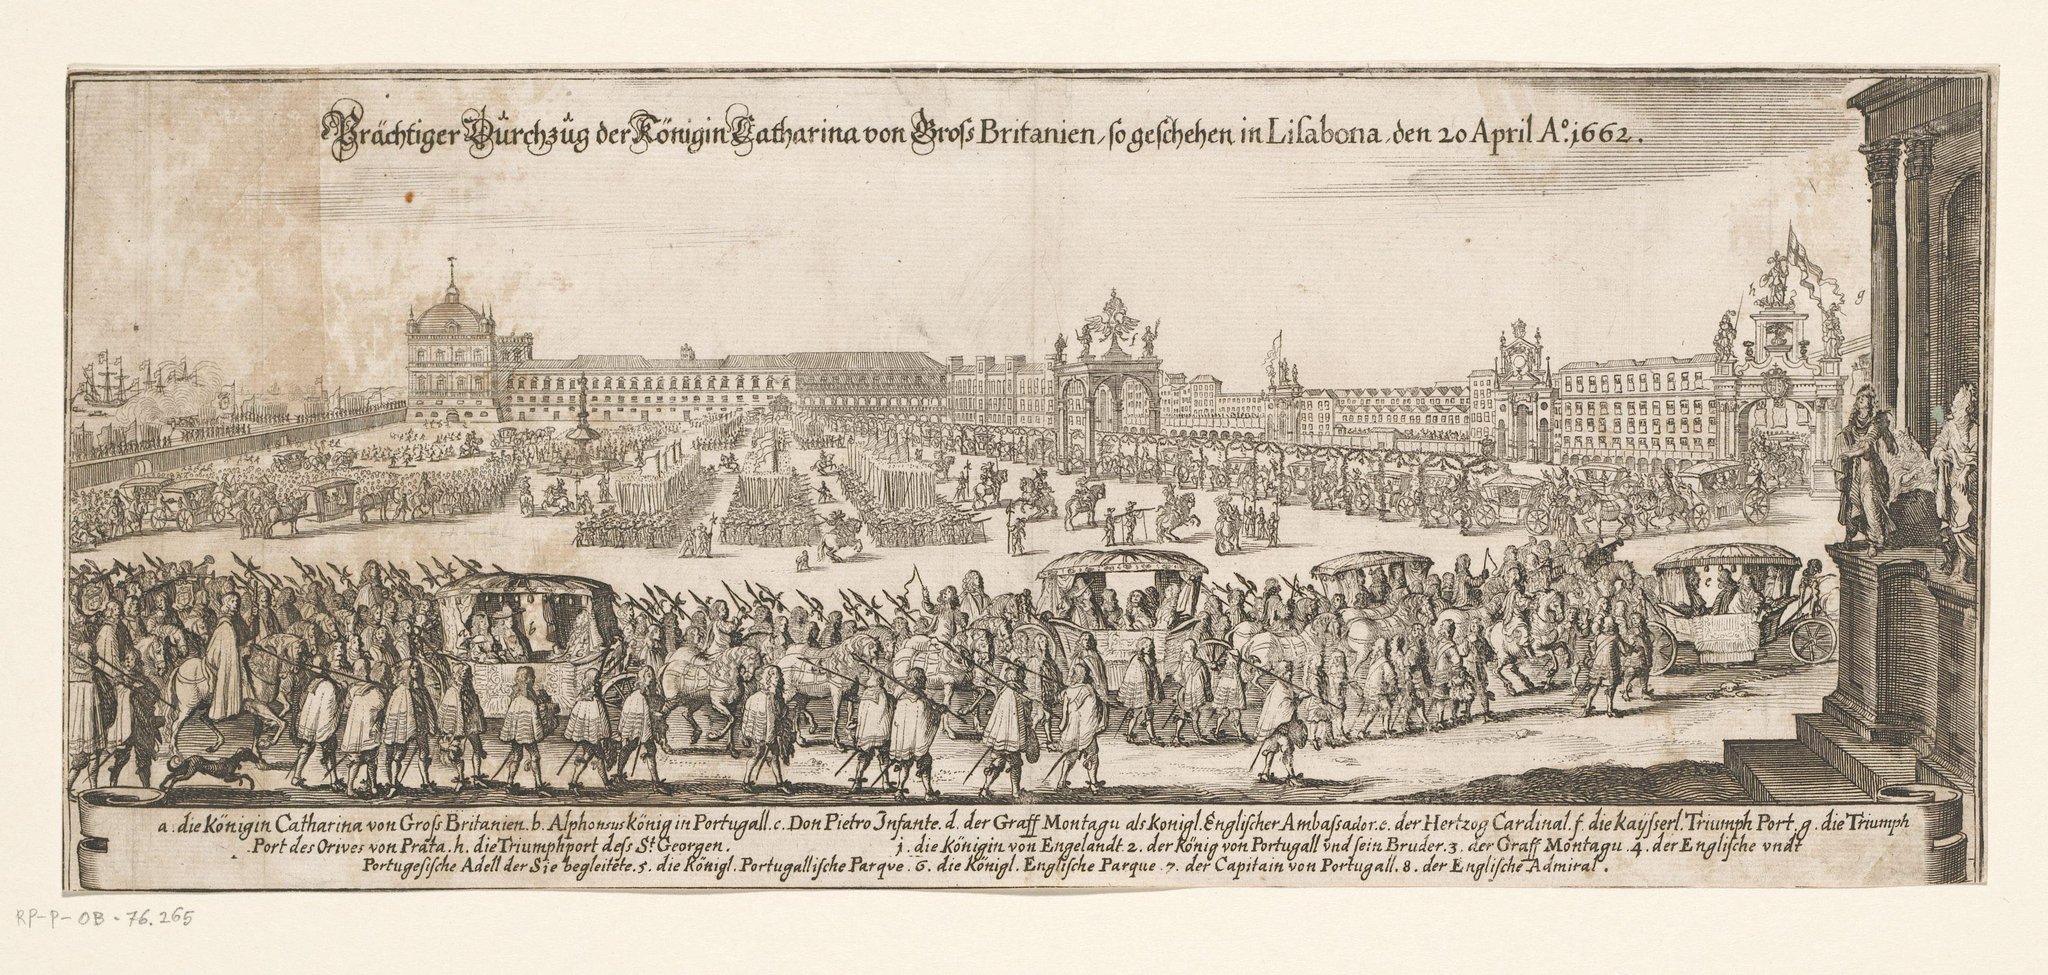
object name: print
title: Prächtiger Durchzug der Königin Catharina von Gross Britanien, so geschehen in Lisabona den 20 April Ao. 1662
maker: matthäus merian (ii)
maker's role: painter, print maker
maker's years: 1621-1687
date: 1662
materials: paper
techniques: etching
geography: germany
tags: catharina van bragança, karel ii (koning van engeland), public festivities at marriage of royal persons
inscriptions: collector's mark: Lugt 2228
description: Vertrek van Catharina van Bragança uit Lissabon naar Engeland voor haar huwelijk, 20 (of 23) april 1662. De stoet van koetsen op het plein voor het koninklijke Ribeirapaleis. Onderdeel van een serie van vier prenten over het huwelijk van Catharina van Bragança en de Engelse koning Karel II op 21 mei 1662.